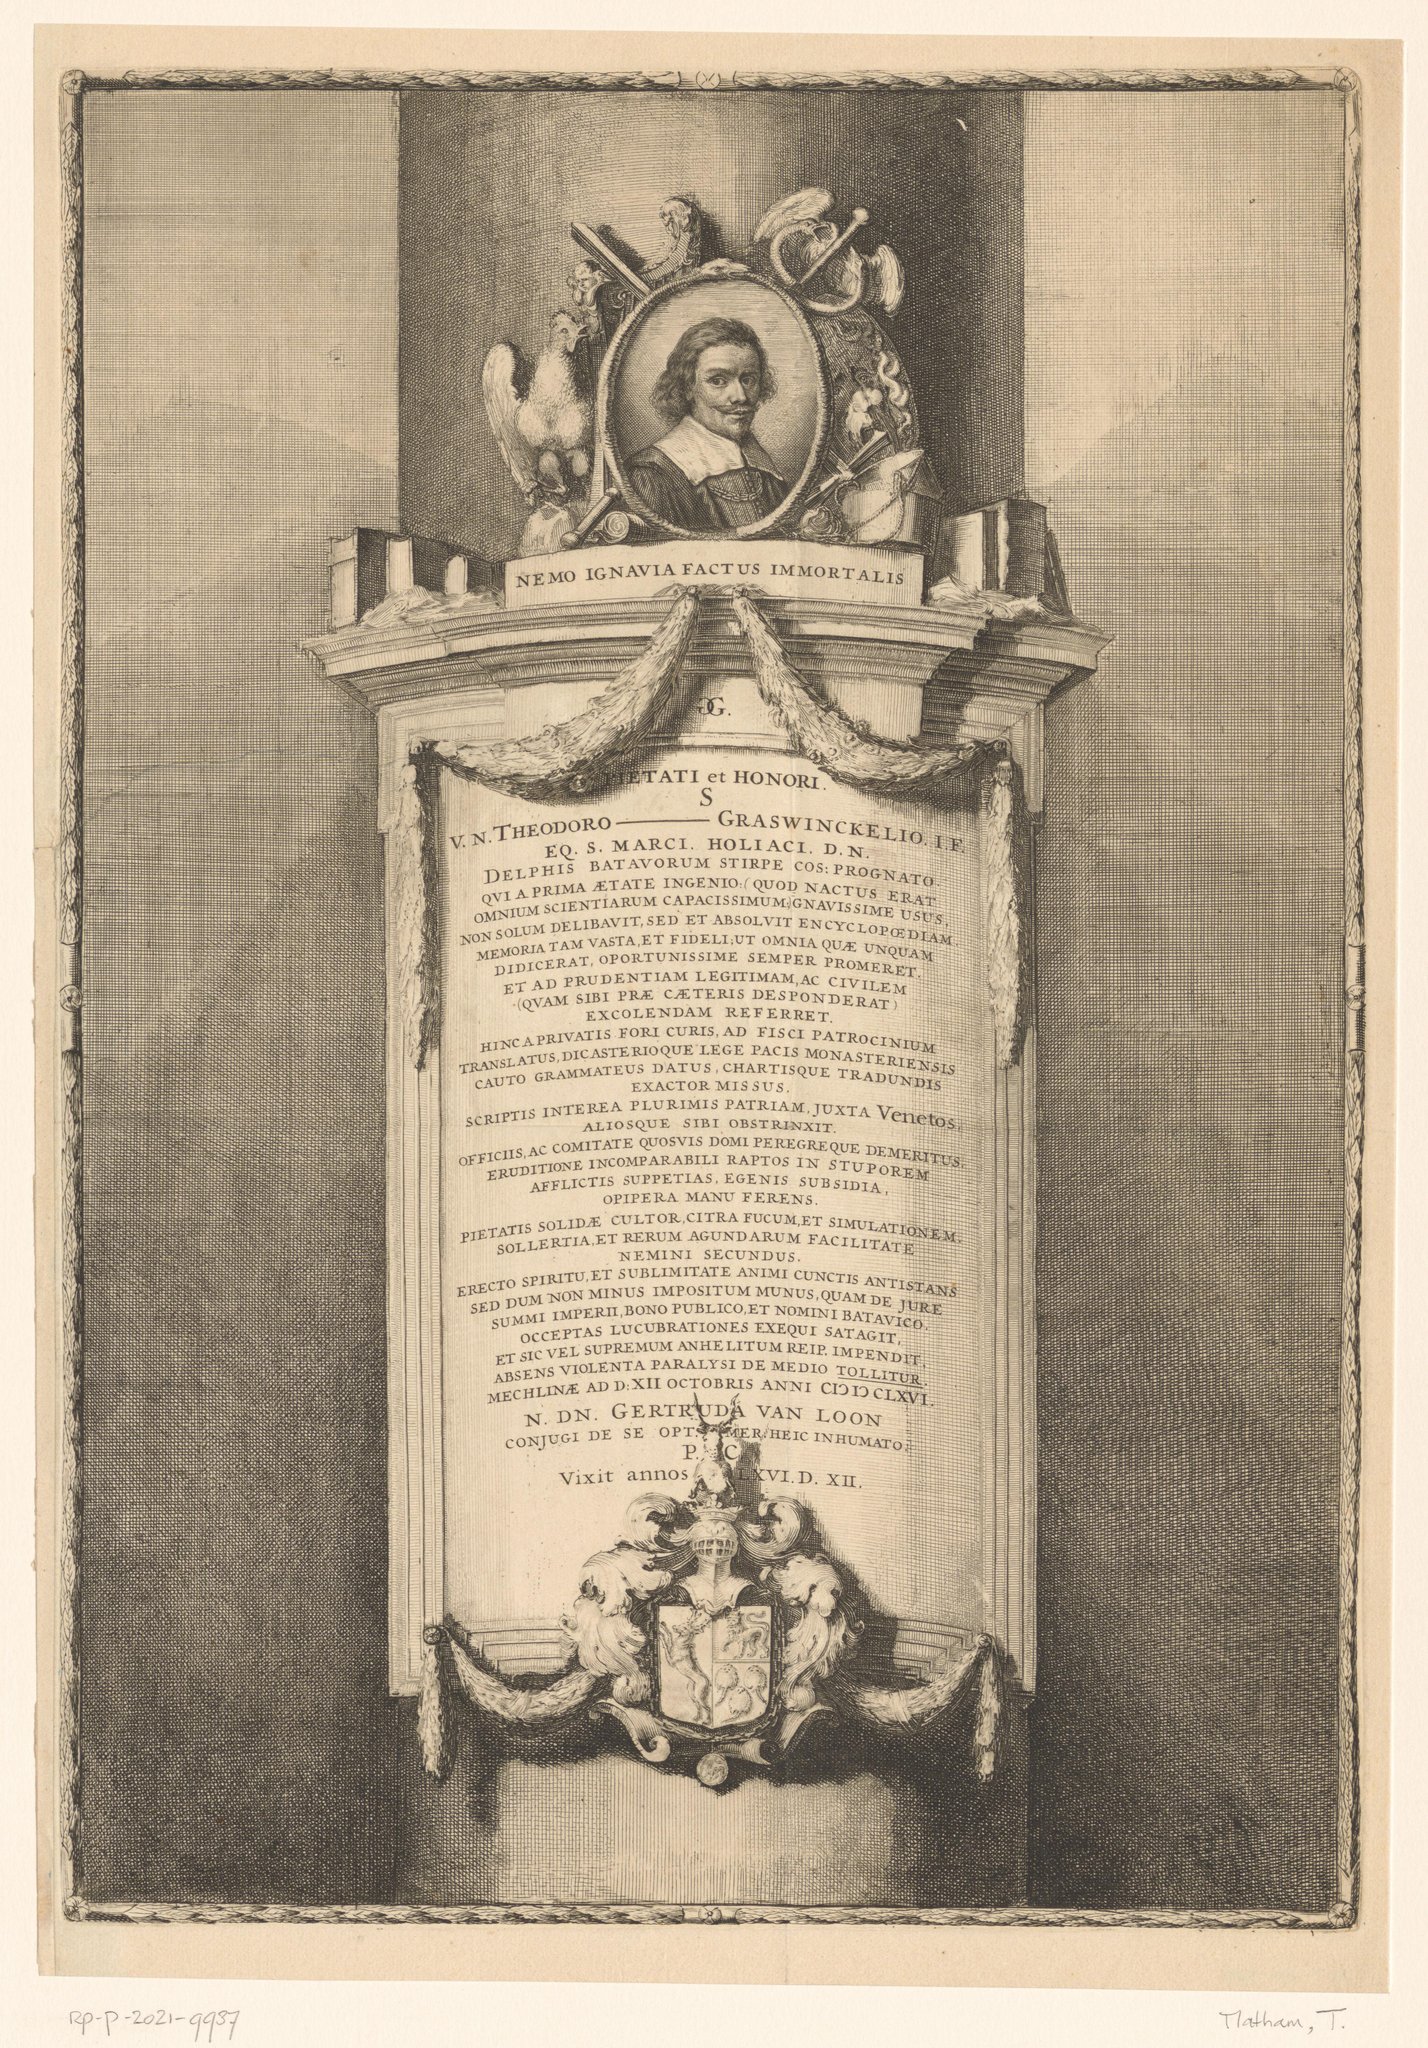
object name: print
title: Grafmonument van Theodorus Johannes Dirk Graswinckel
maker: theodor matham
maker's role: draughtsman, print maker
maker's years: 1605-1676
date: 1666-1676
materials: paper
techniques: engraving, etching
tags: delft, mechelen, theodorus johannes dirk graswinckel, historical persons, grave, tomb, armorial bearing, heraldry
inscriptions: collector's mark: Lugt 2228